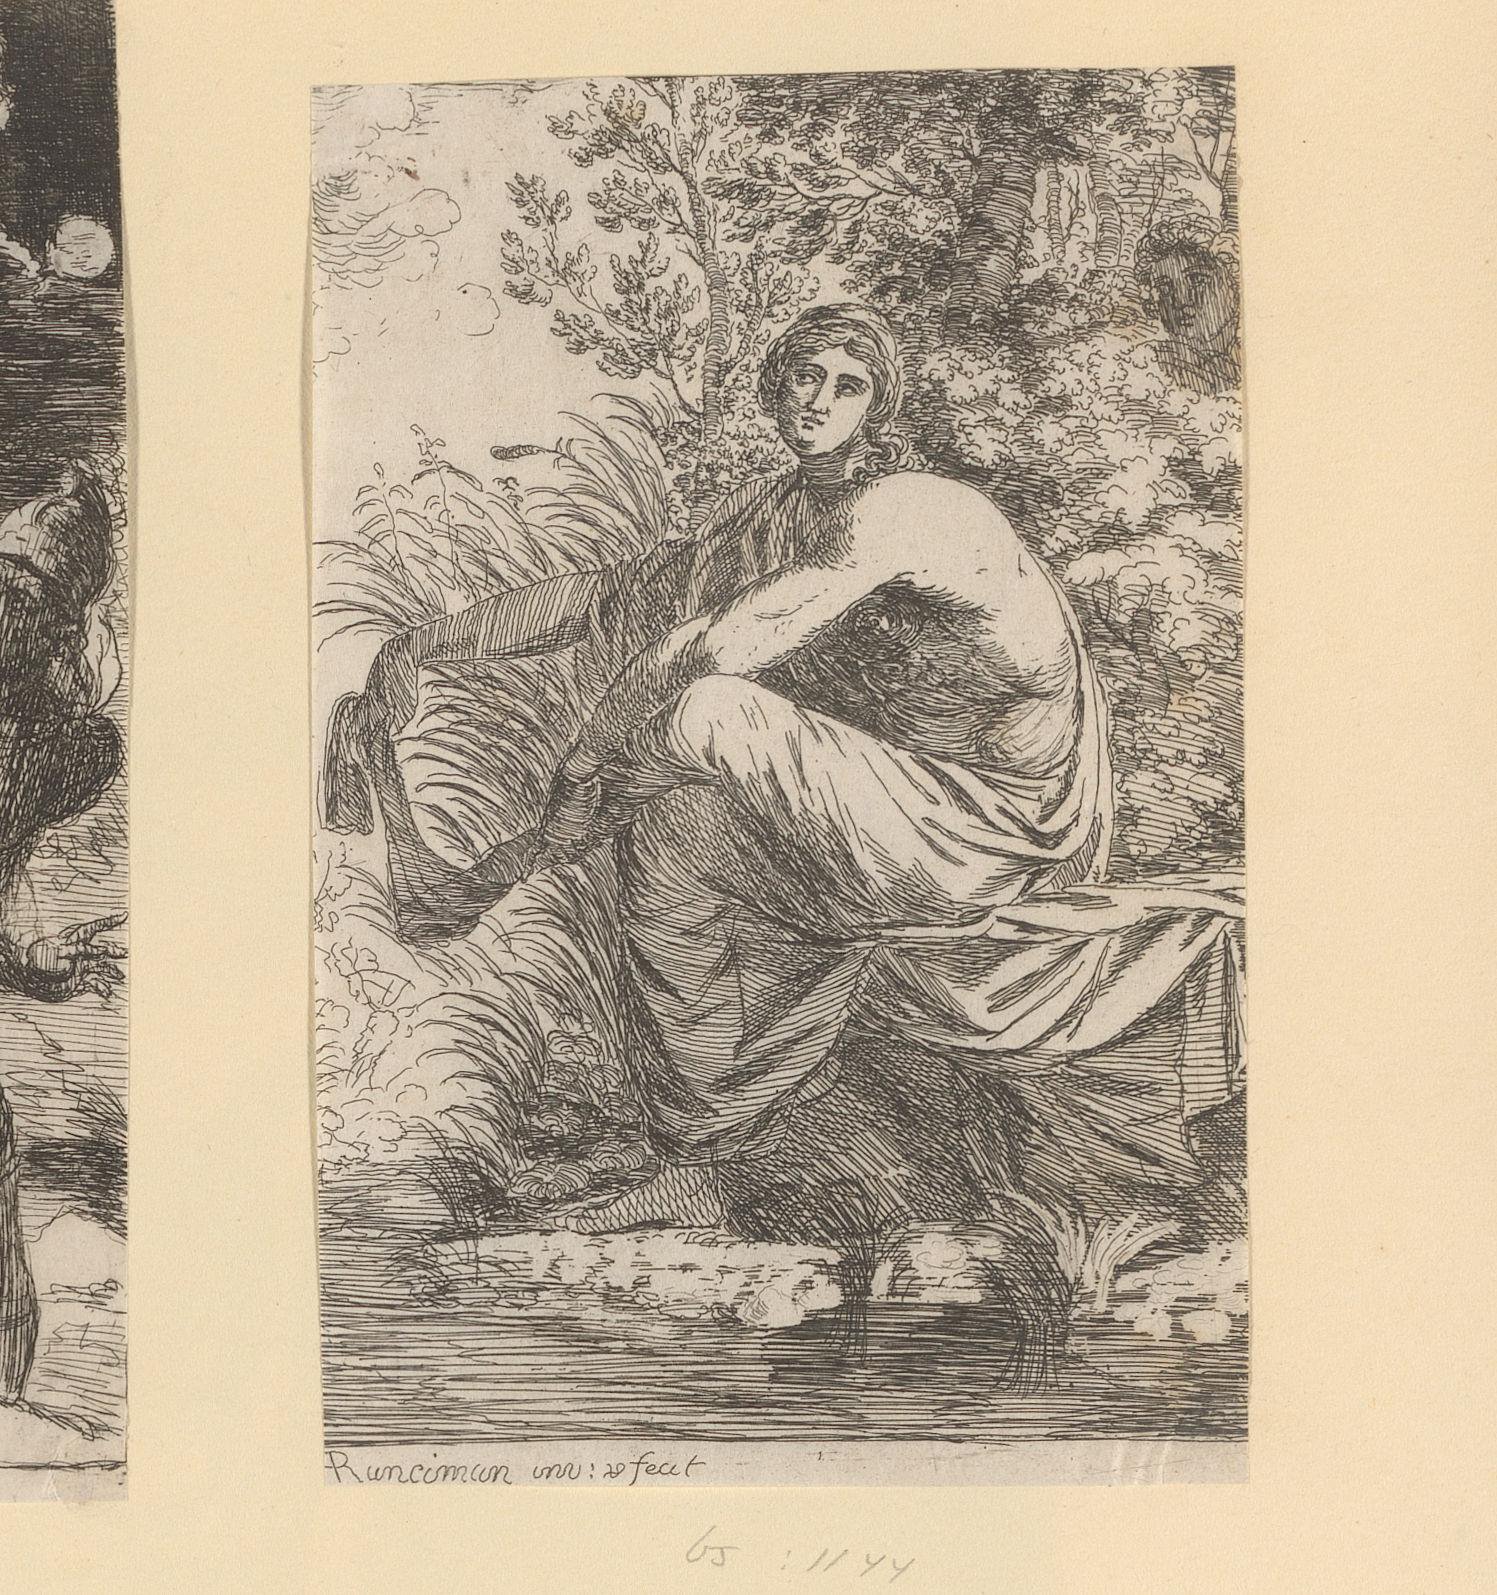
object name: print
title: Badende Diana met Actaeon achter haar verscholen in een struikgewas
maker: alexander runciman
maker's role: draughtsman, print maker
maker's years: 1736-1785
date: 1746-1785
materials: paper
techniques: etching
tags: actaeon changed into a stag: as punishment for seeing her bathe, diana changes actaeon, the hunter, into a stag (ovid, metamorphoses iii 193), diana bathing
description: Prent maakt mogelijk deel uit van een serie van 200 prenten. Deze serie is onder de titel 'A Collection of two hundred original etchings' voor het eerst uitgegeven door J.M. Greery in 1816.